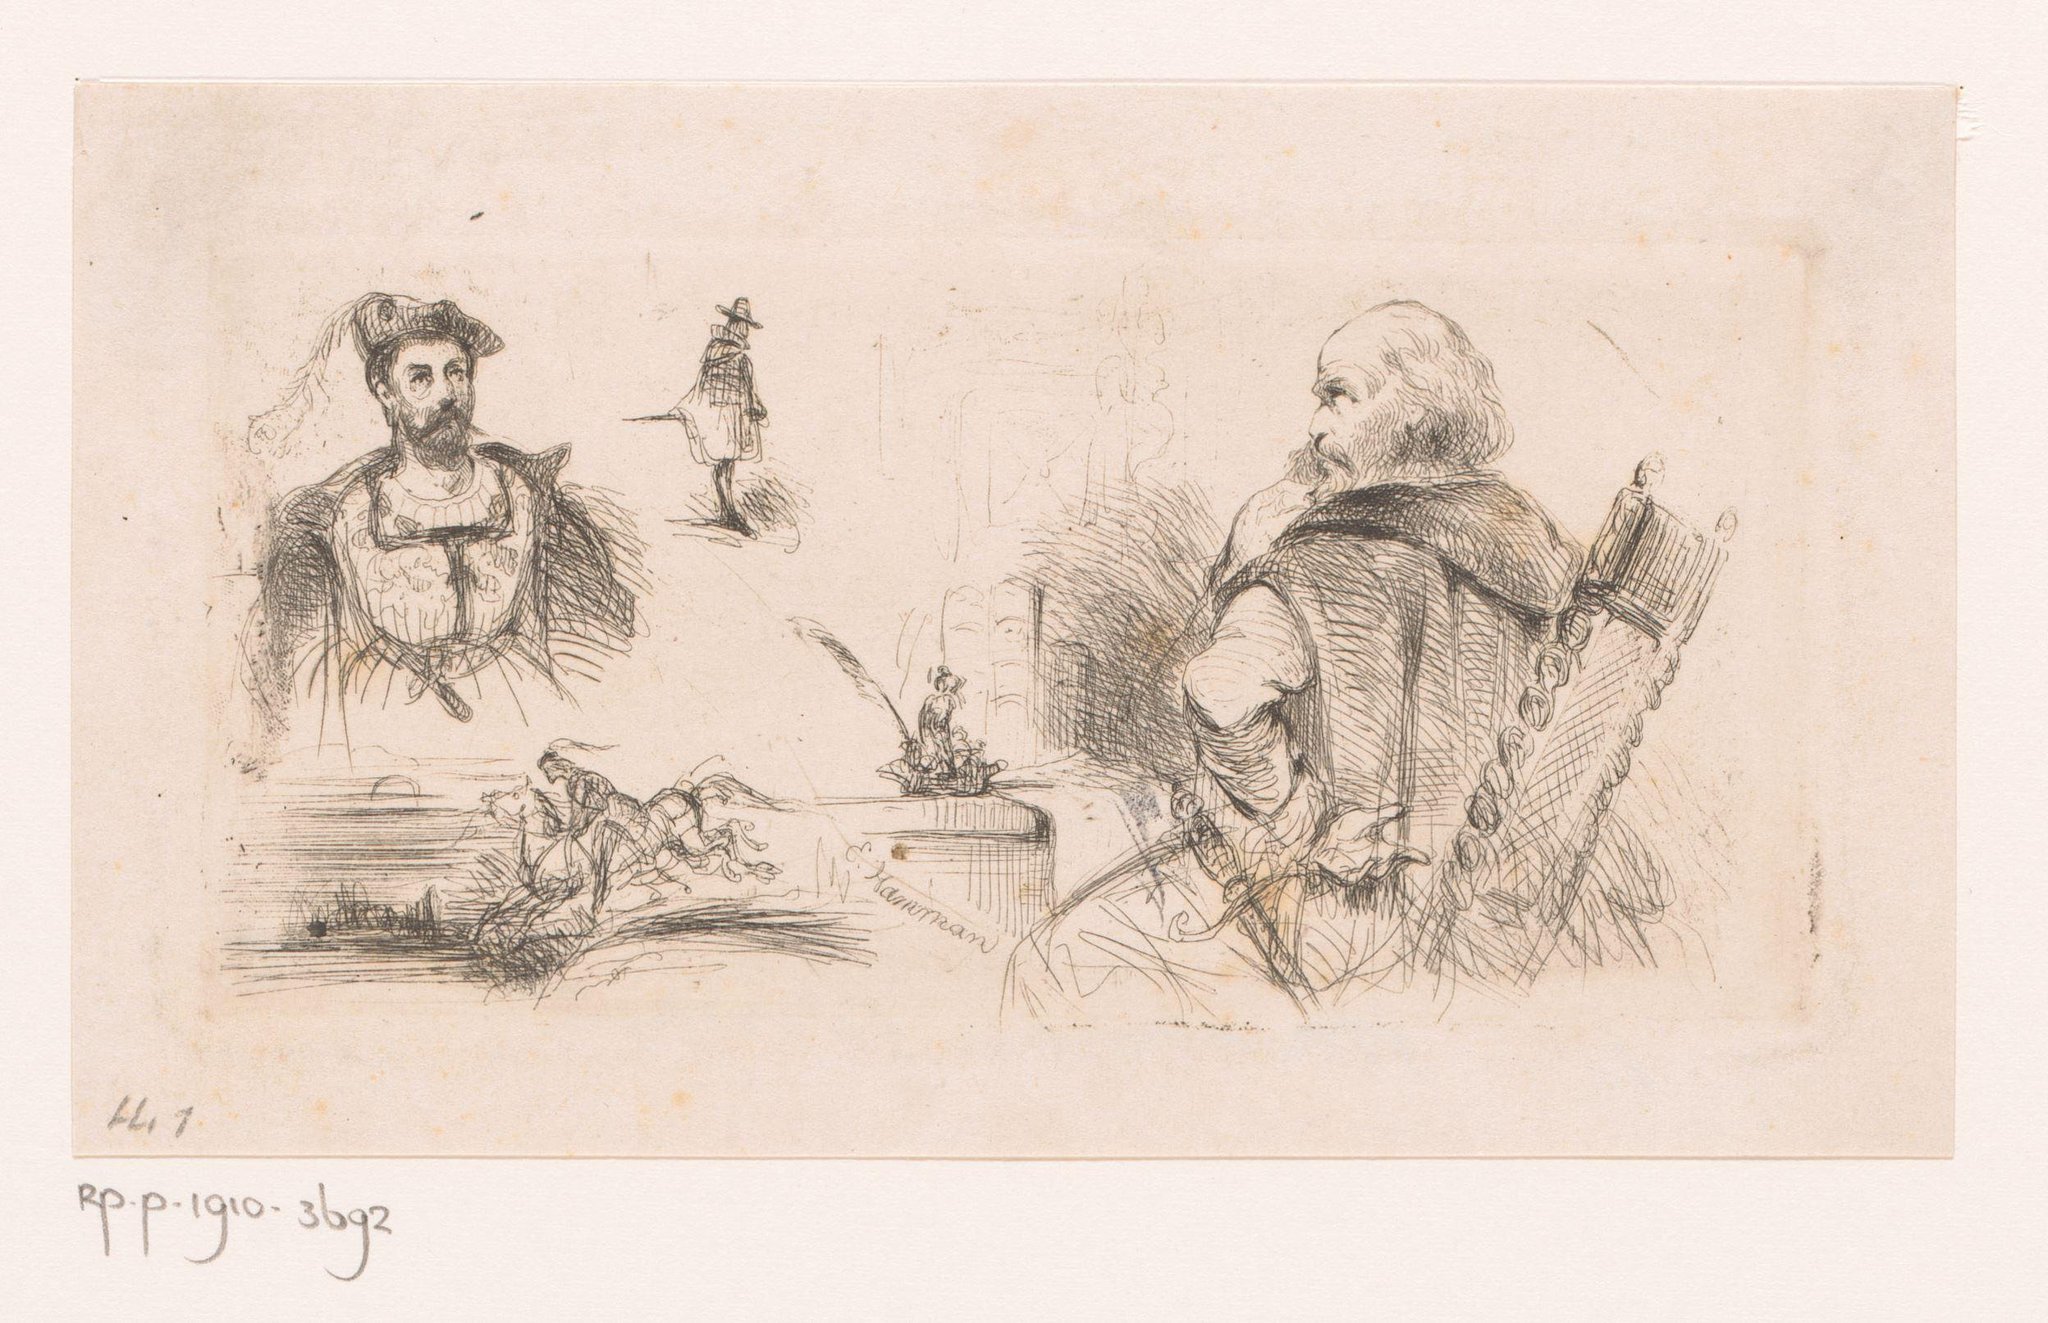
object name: print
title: Studieblad met portretten van onbekende mannen en een ridder te paard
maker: edouard hamman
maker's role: draughtsman, print maker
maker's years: 1819-1888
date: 1829-1888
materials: paper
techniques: etching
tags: anonymous historical person portrayed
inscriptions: collector's mark: Lugt 1485, collector's mark: Lugt 2228